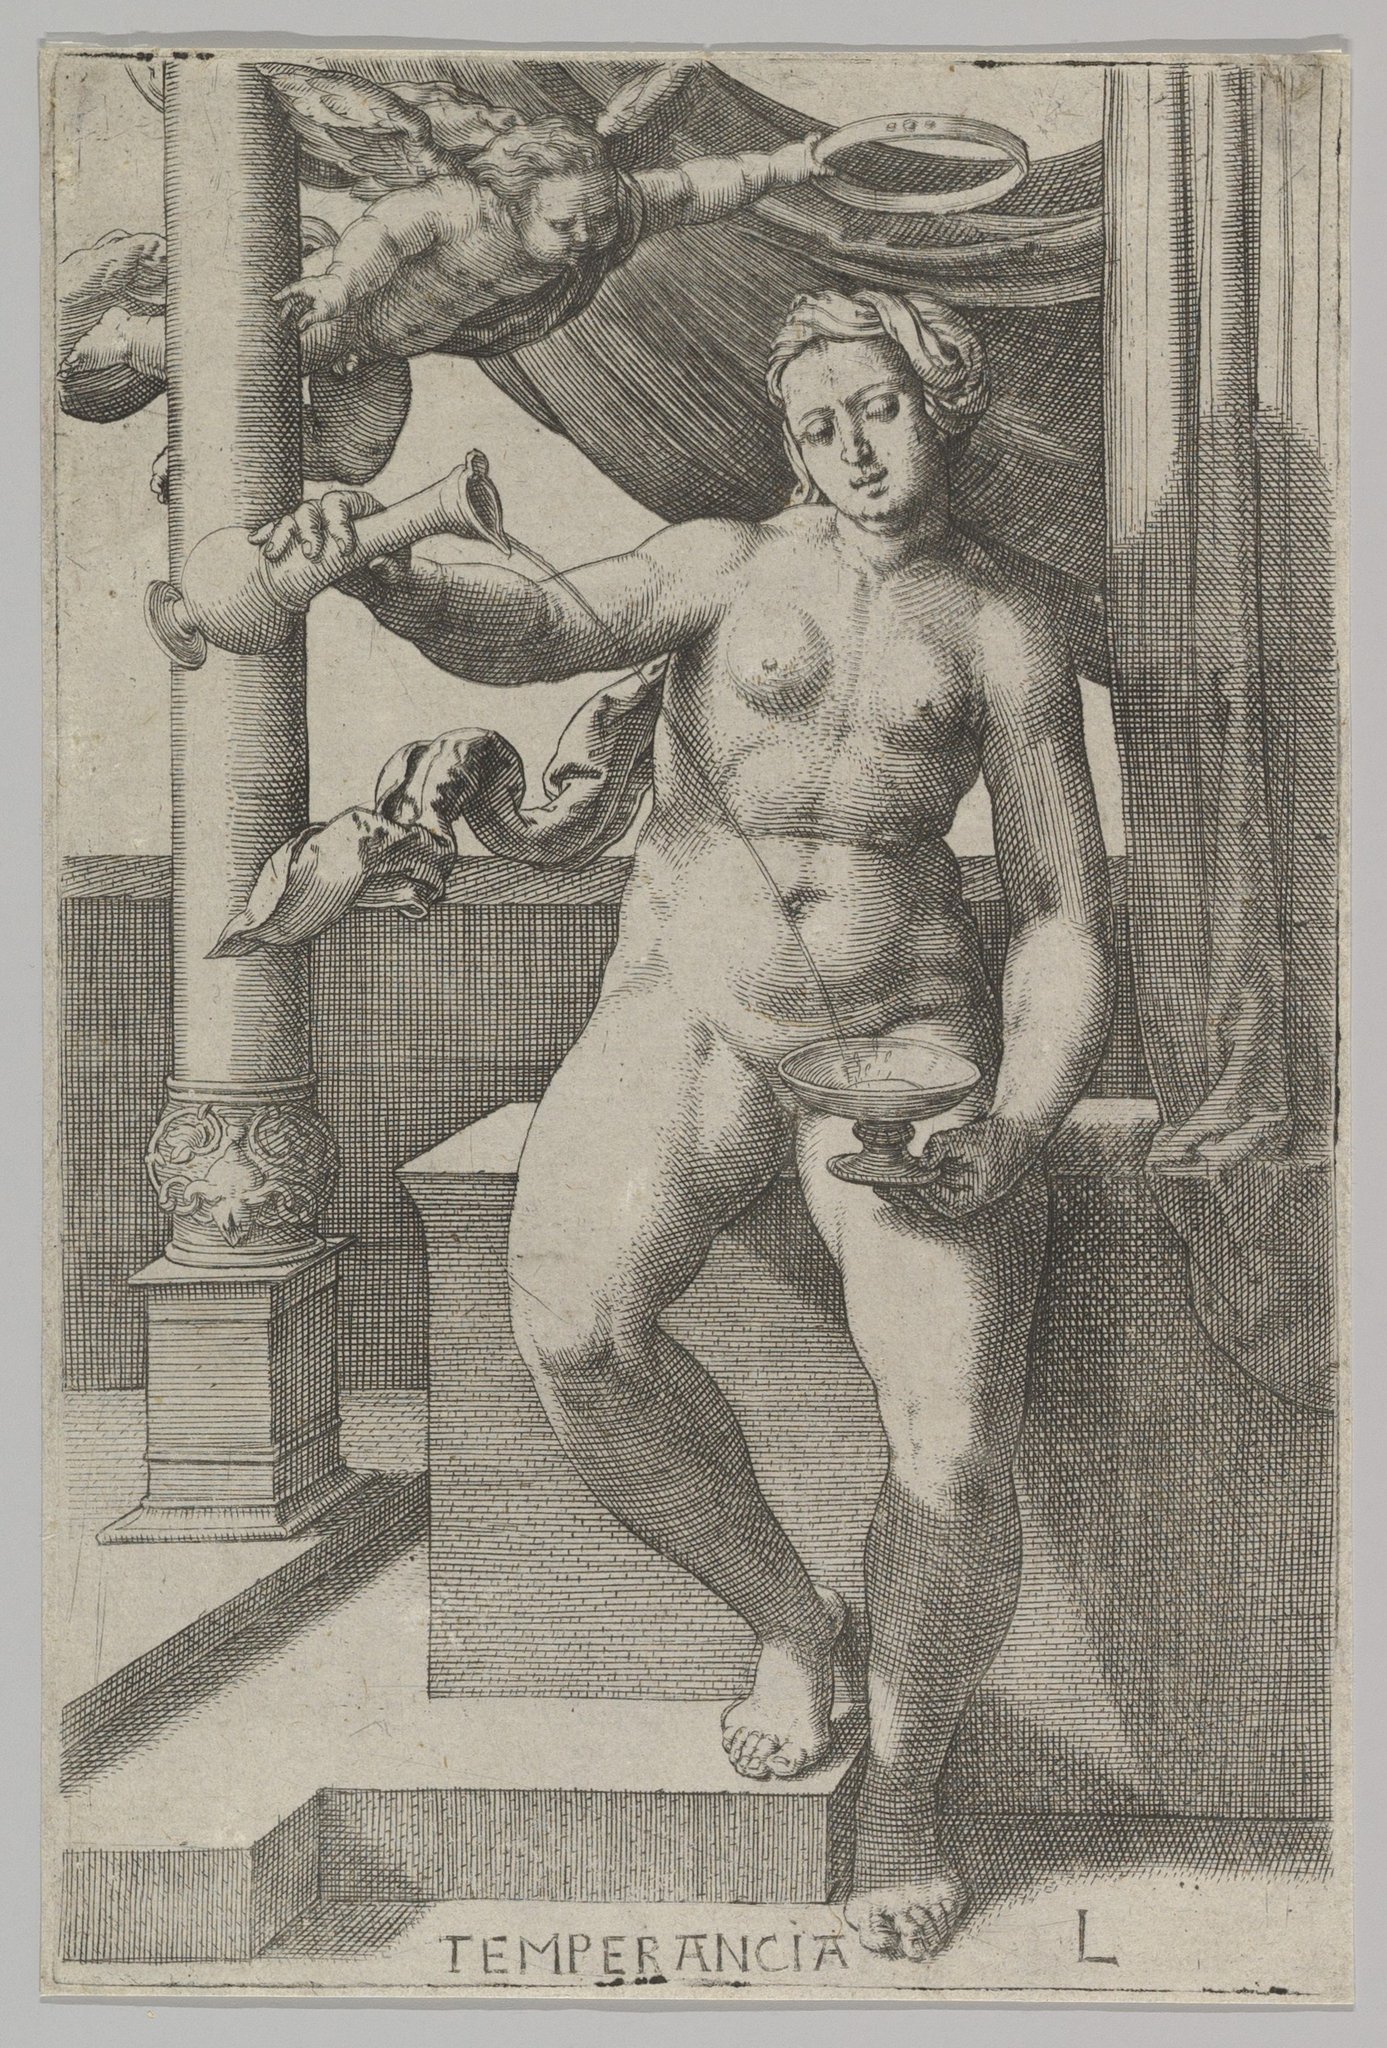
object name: print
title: Temperance, from the series The Virtues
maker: lucas van leyden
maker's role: artist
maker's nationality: netherlandish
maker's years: 1494-1533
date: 1530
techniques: engraving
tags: female nudes